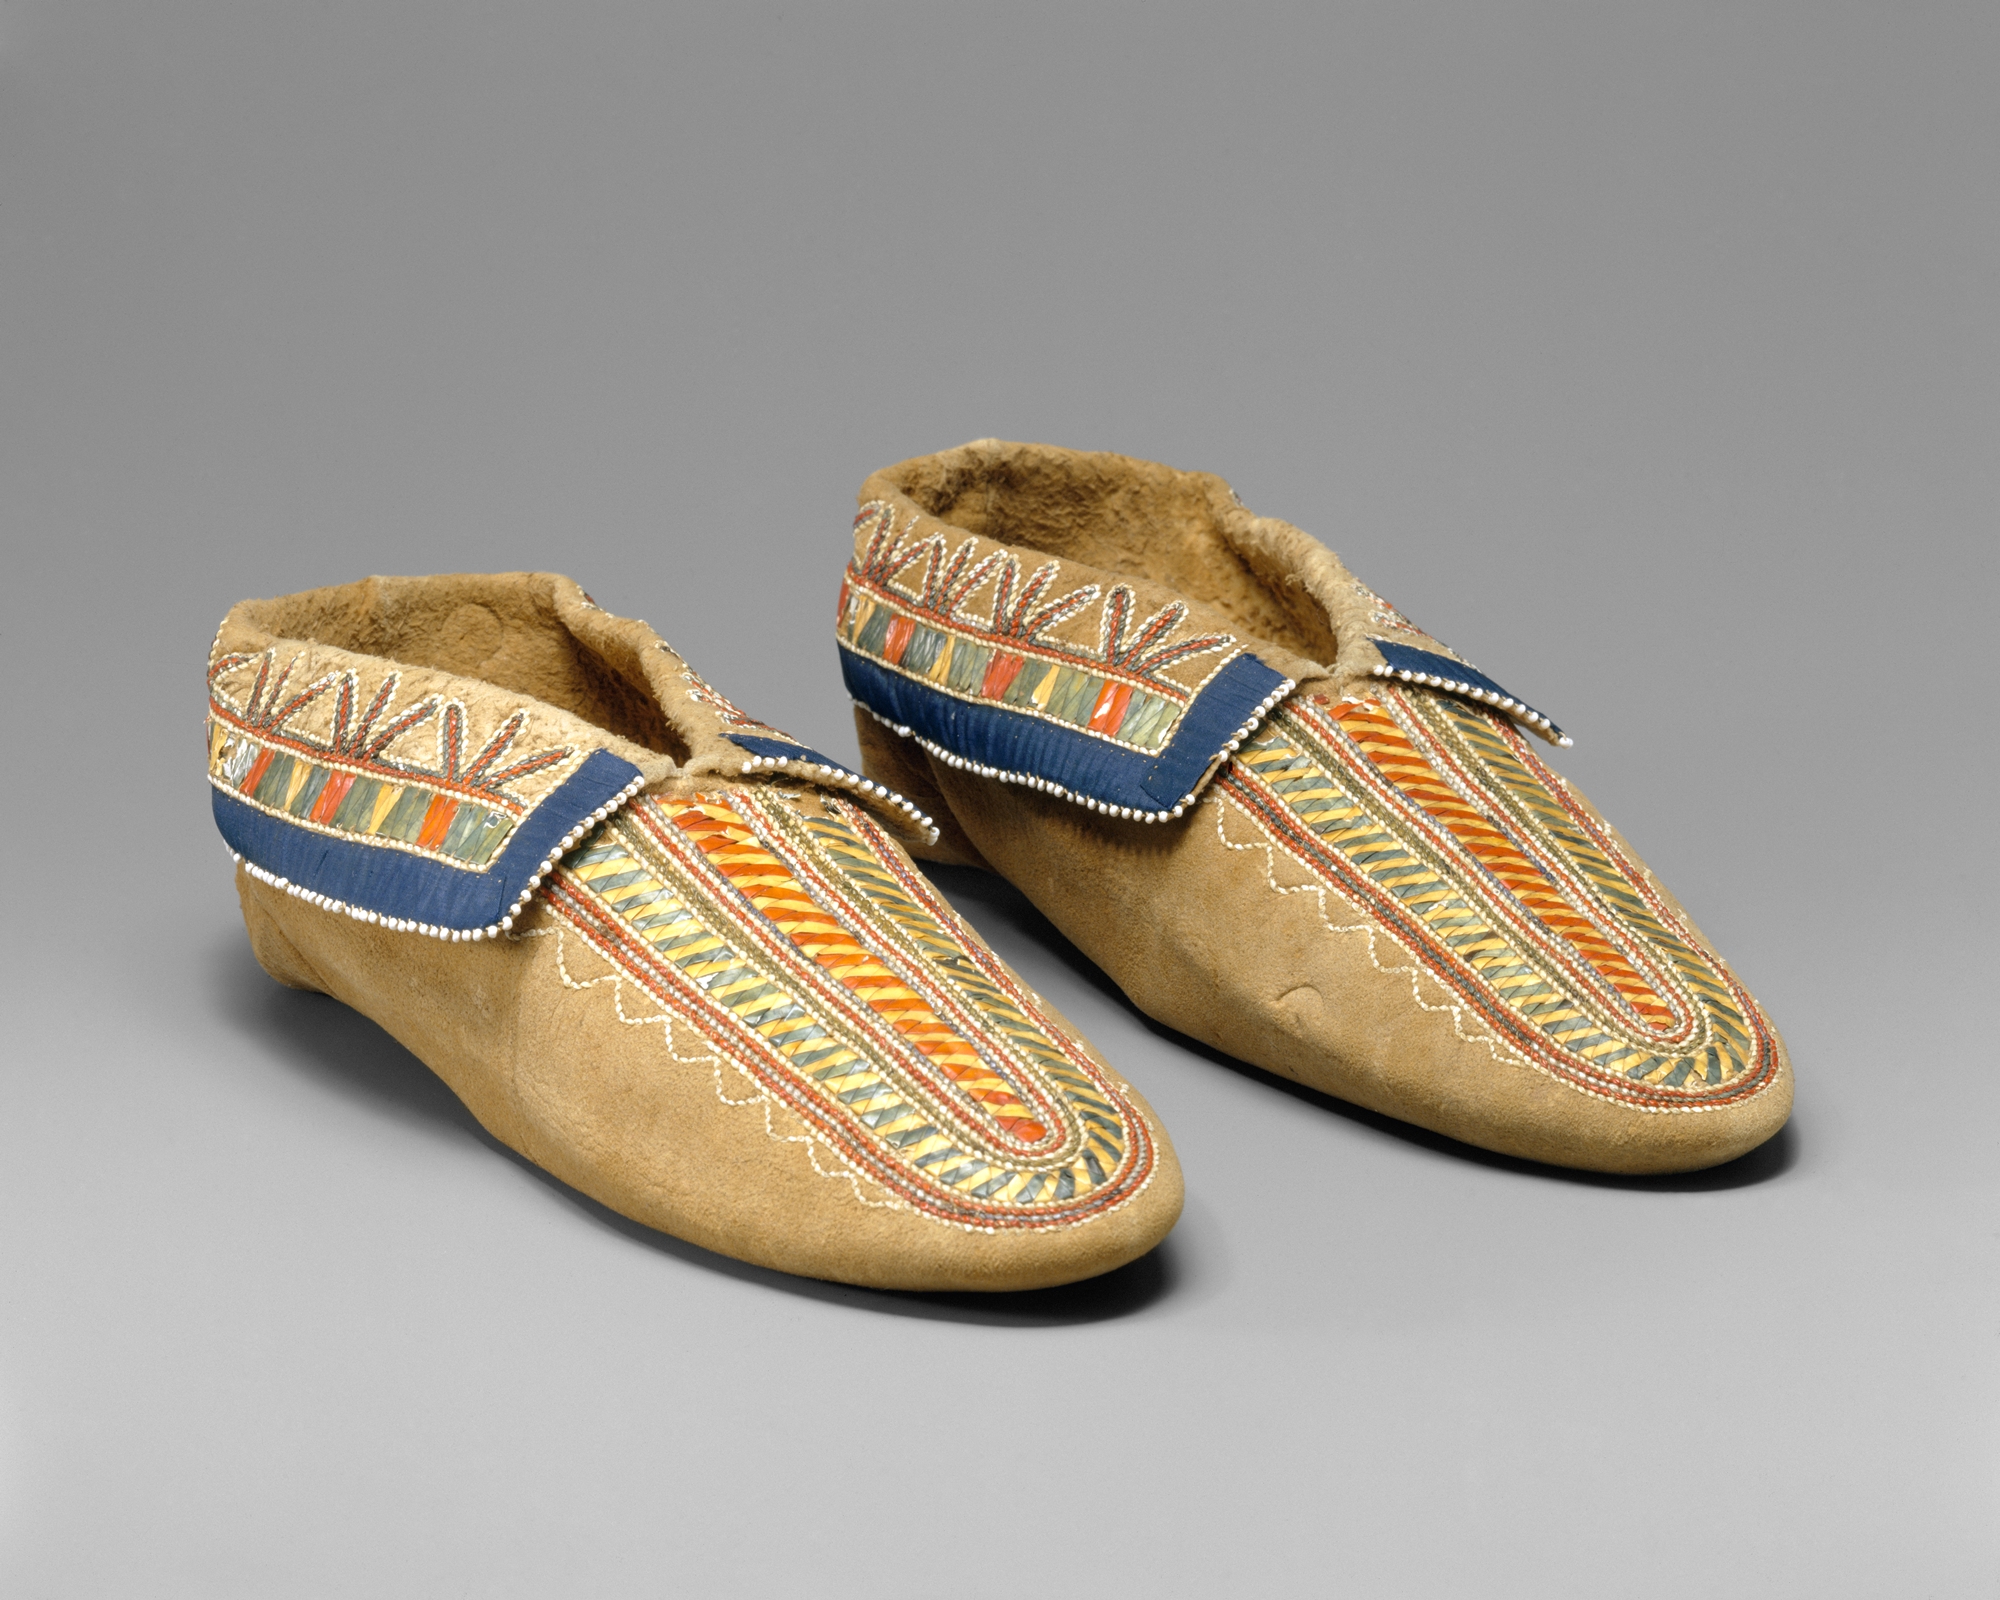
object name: moccasin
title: Pair of Moccasins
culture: seneca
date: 1830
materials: glass, silk, skin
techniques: tanning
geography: united states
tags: shoes